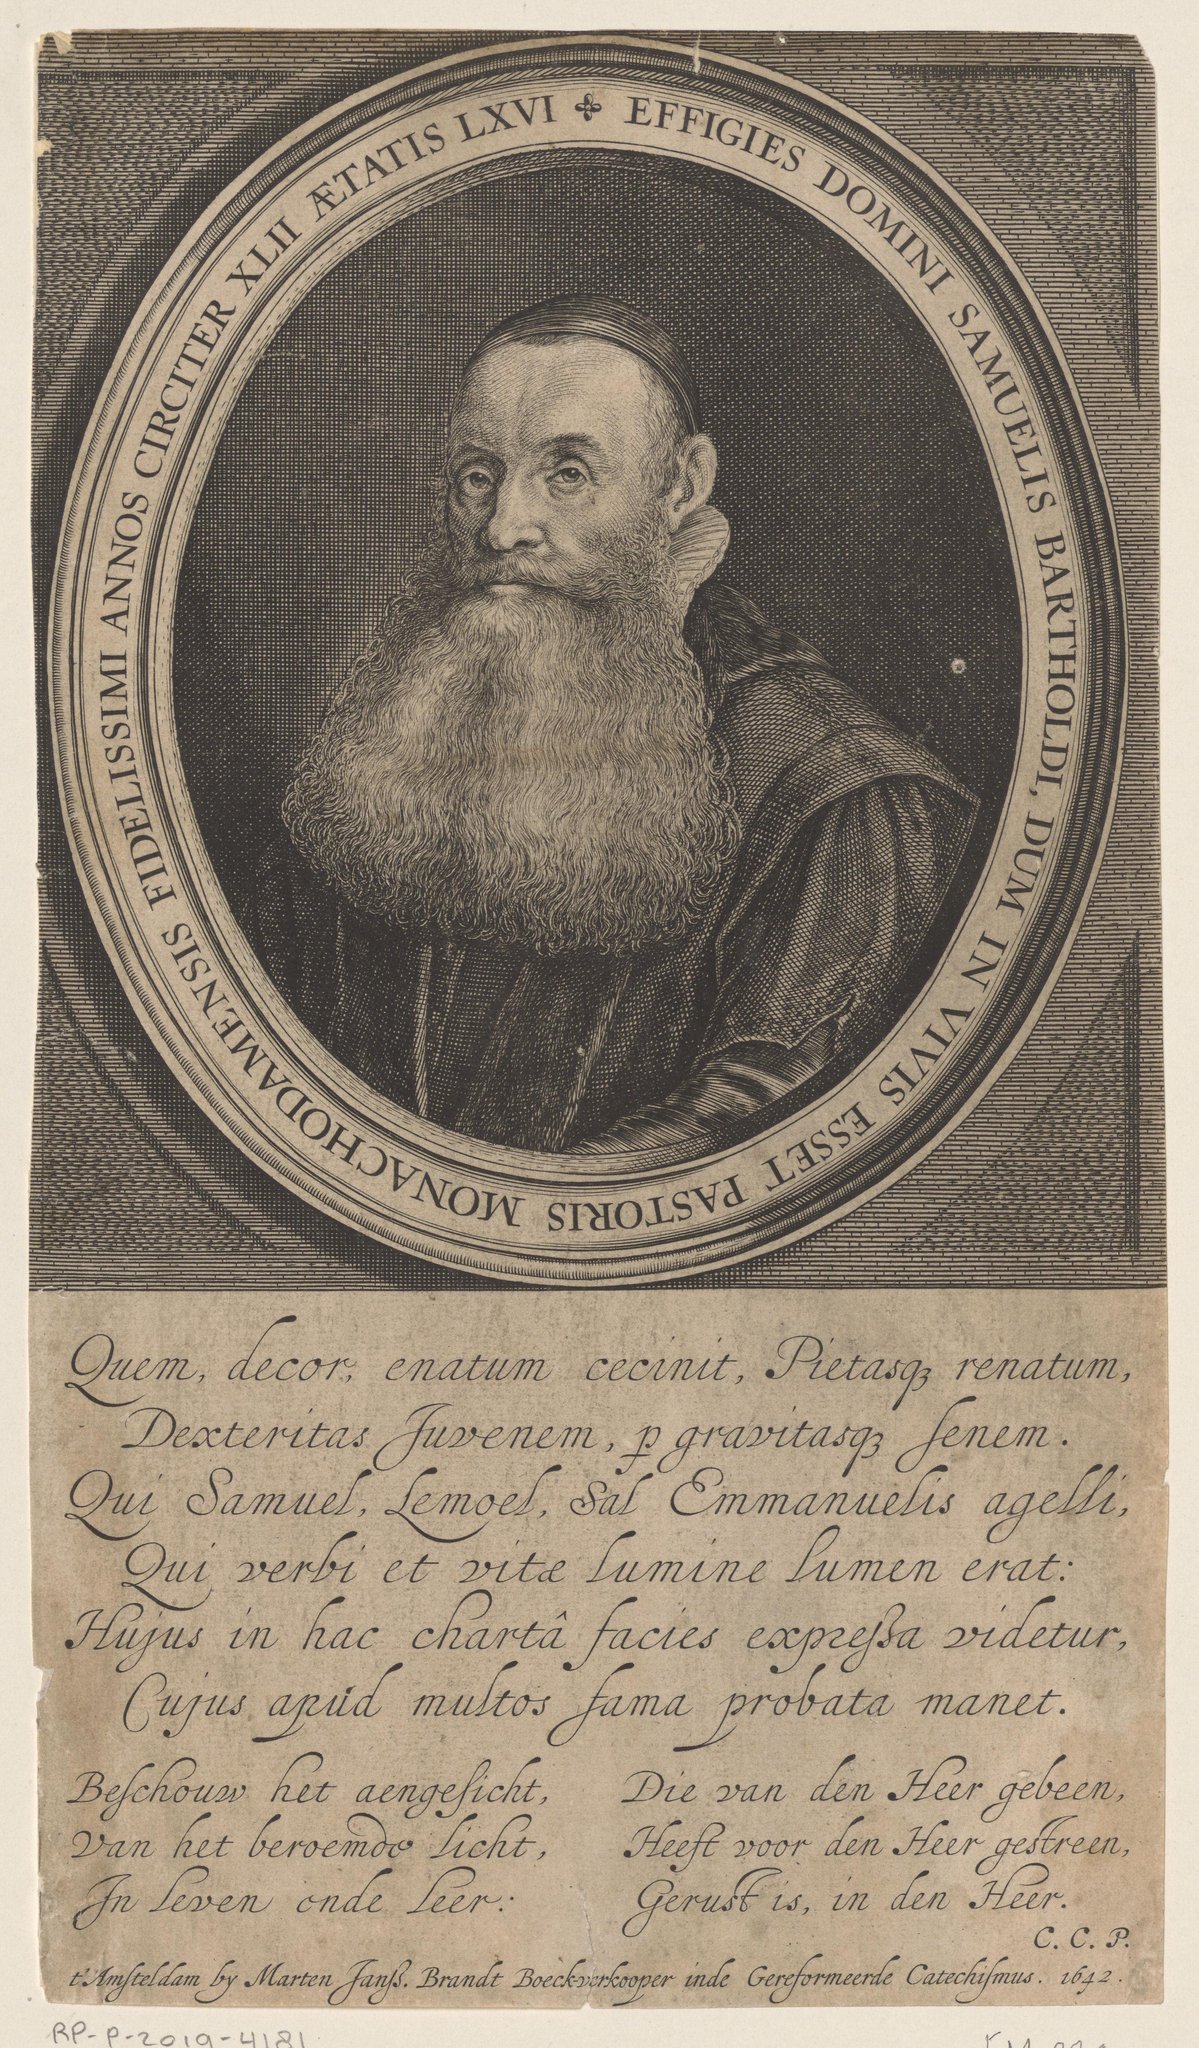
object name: print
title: Portret van Samuel Bartholdi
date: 1642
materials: paper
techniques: engraving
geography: amsterdam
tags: historical persons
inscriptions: date